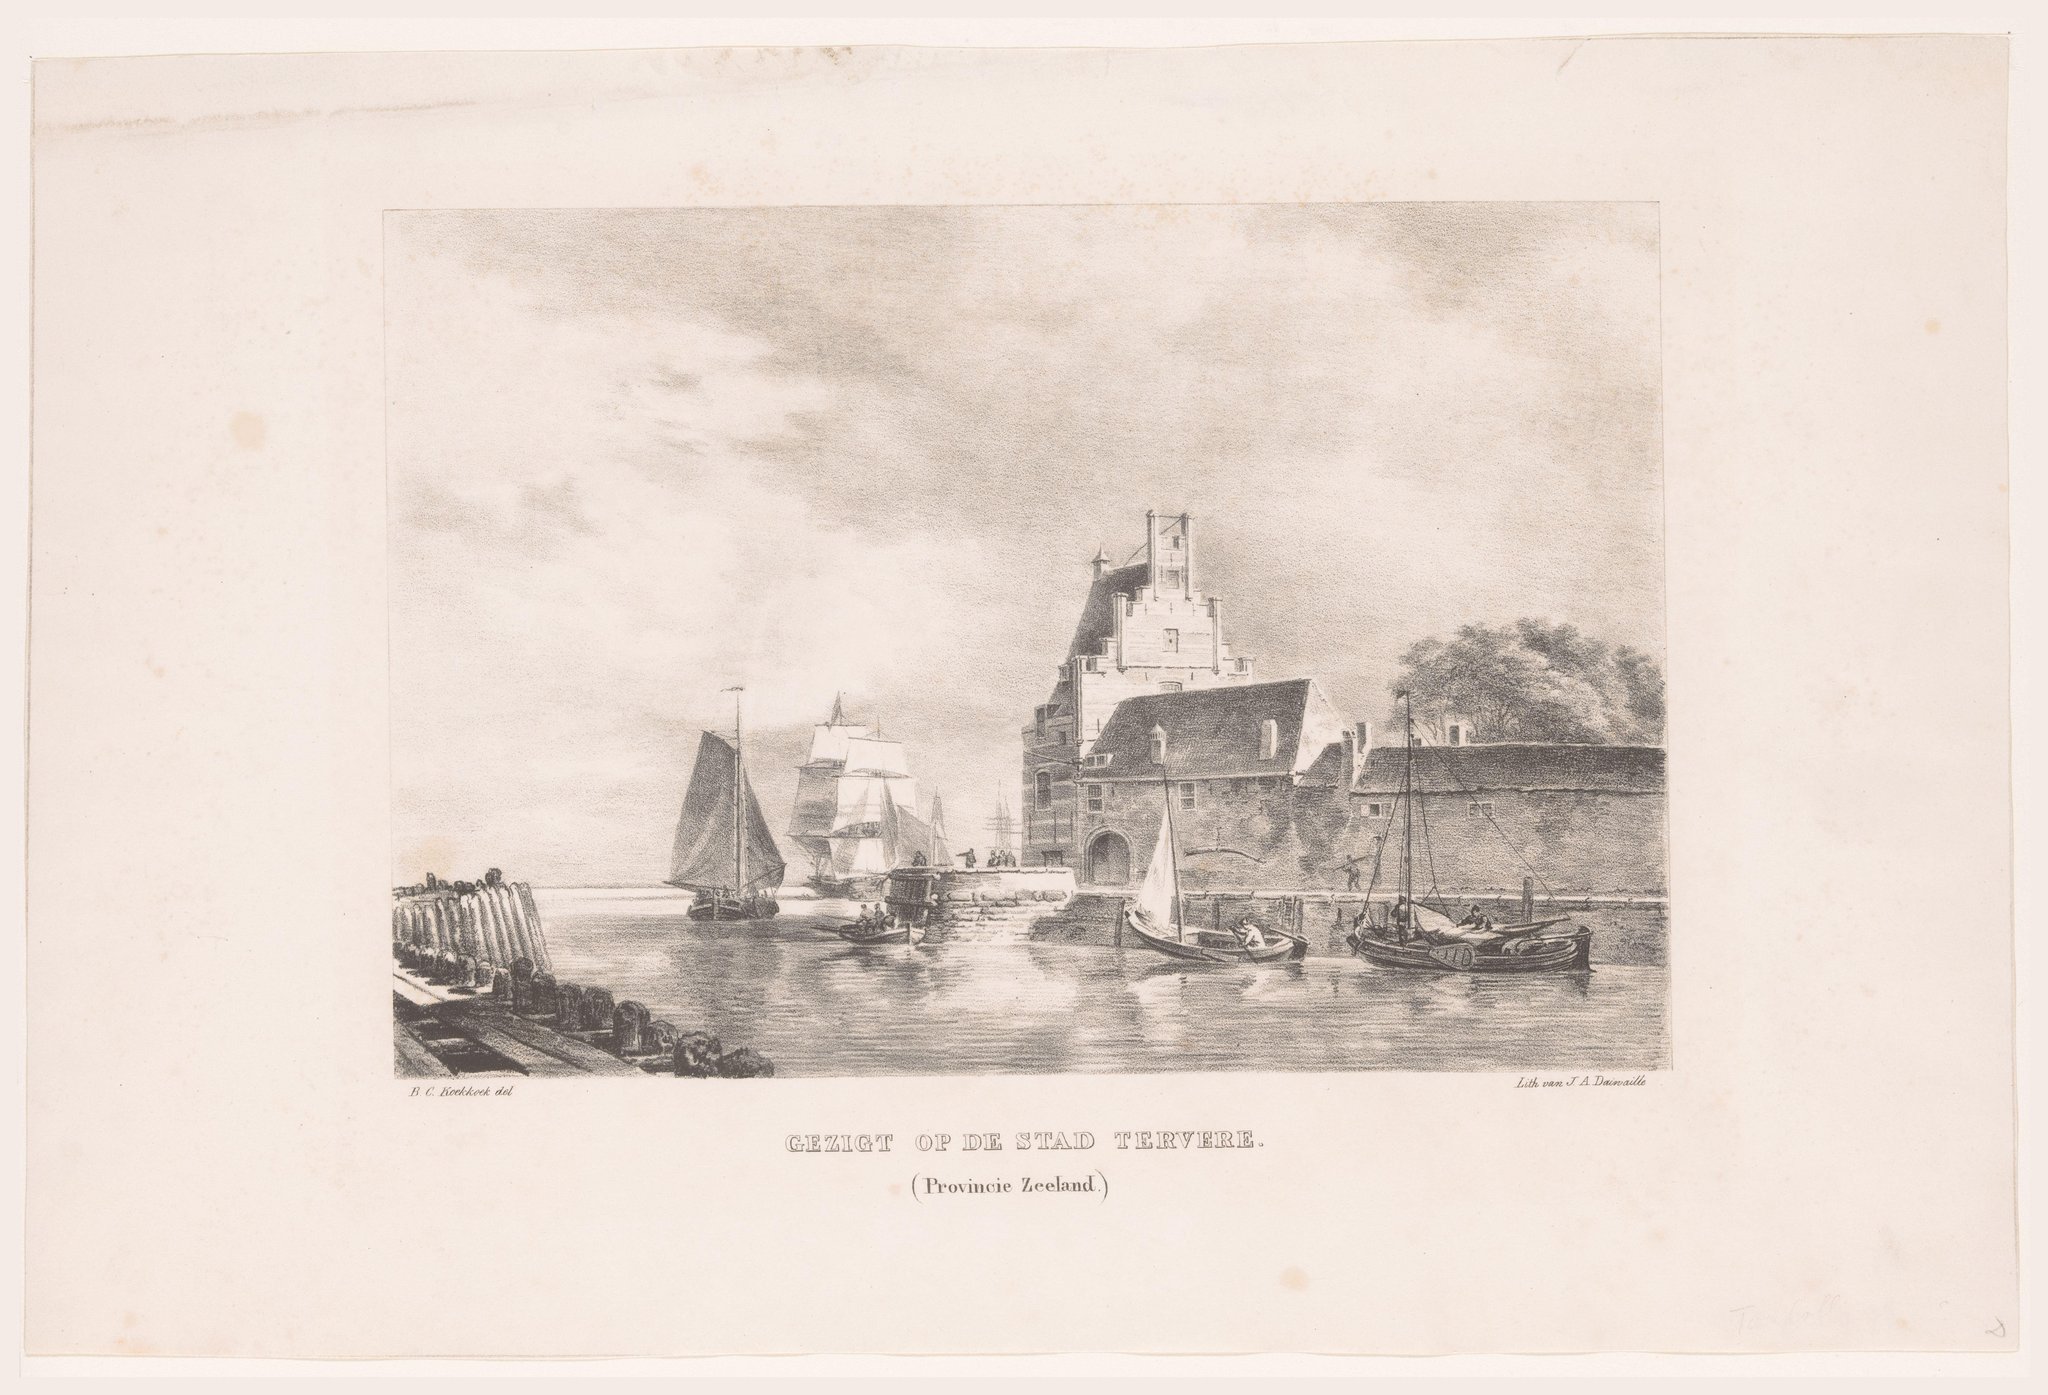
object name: print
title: Gezicht op Veere te Zeeland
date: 1831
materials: paper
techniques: lithograph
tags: harbour, sailing-ship, sailing-boat